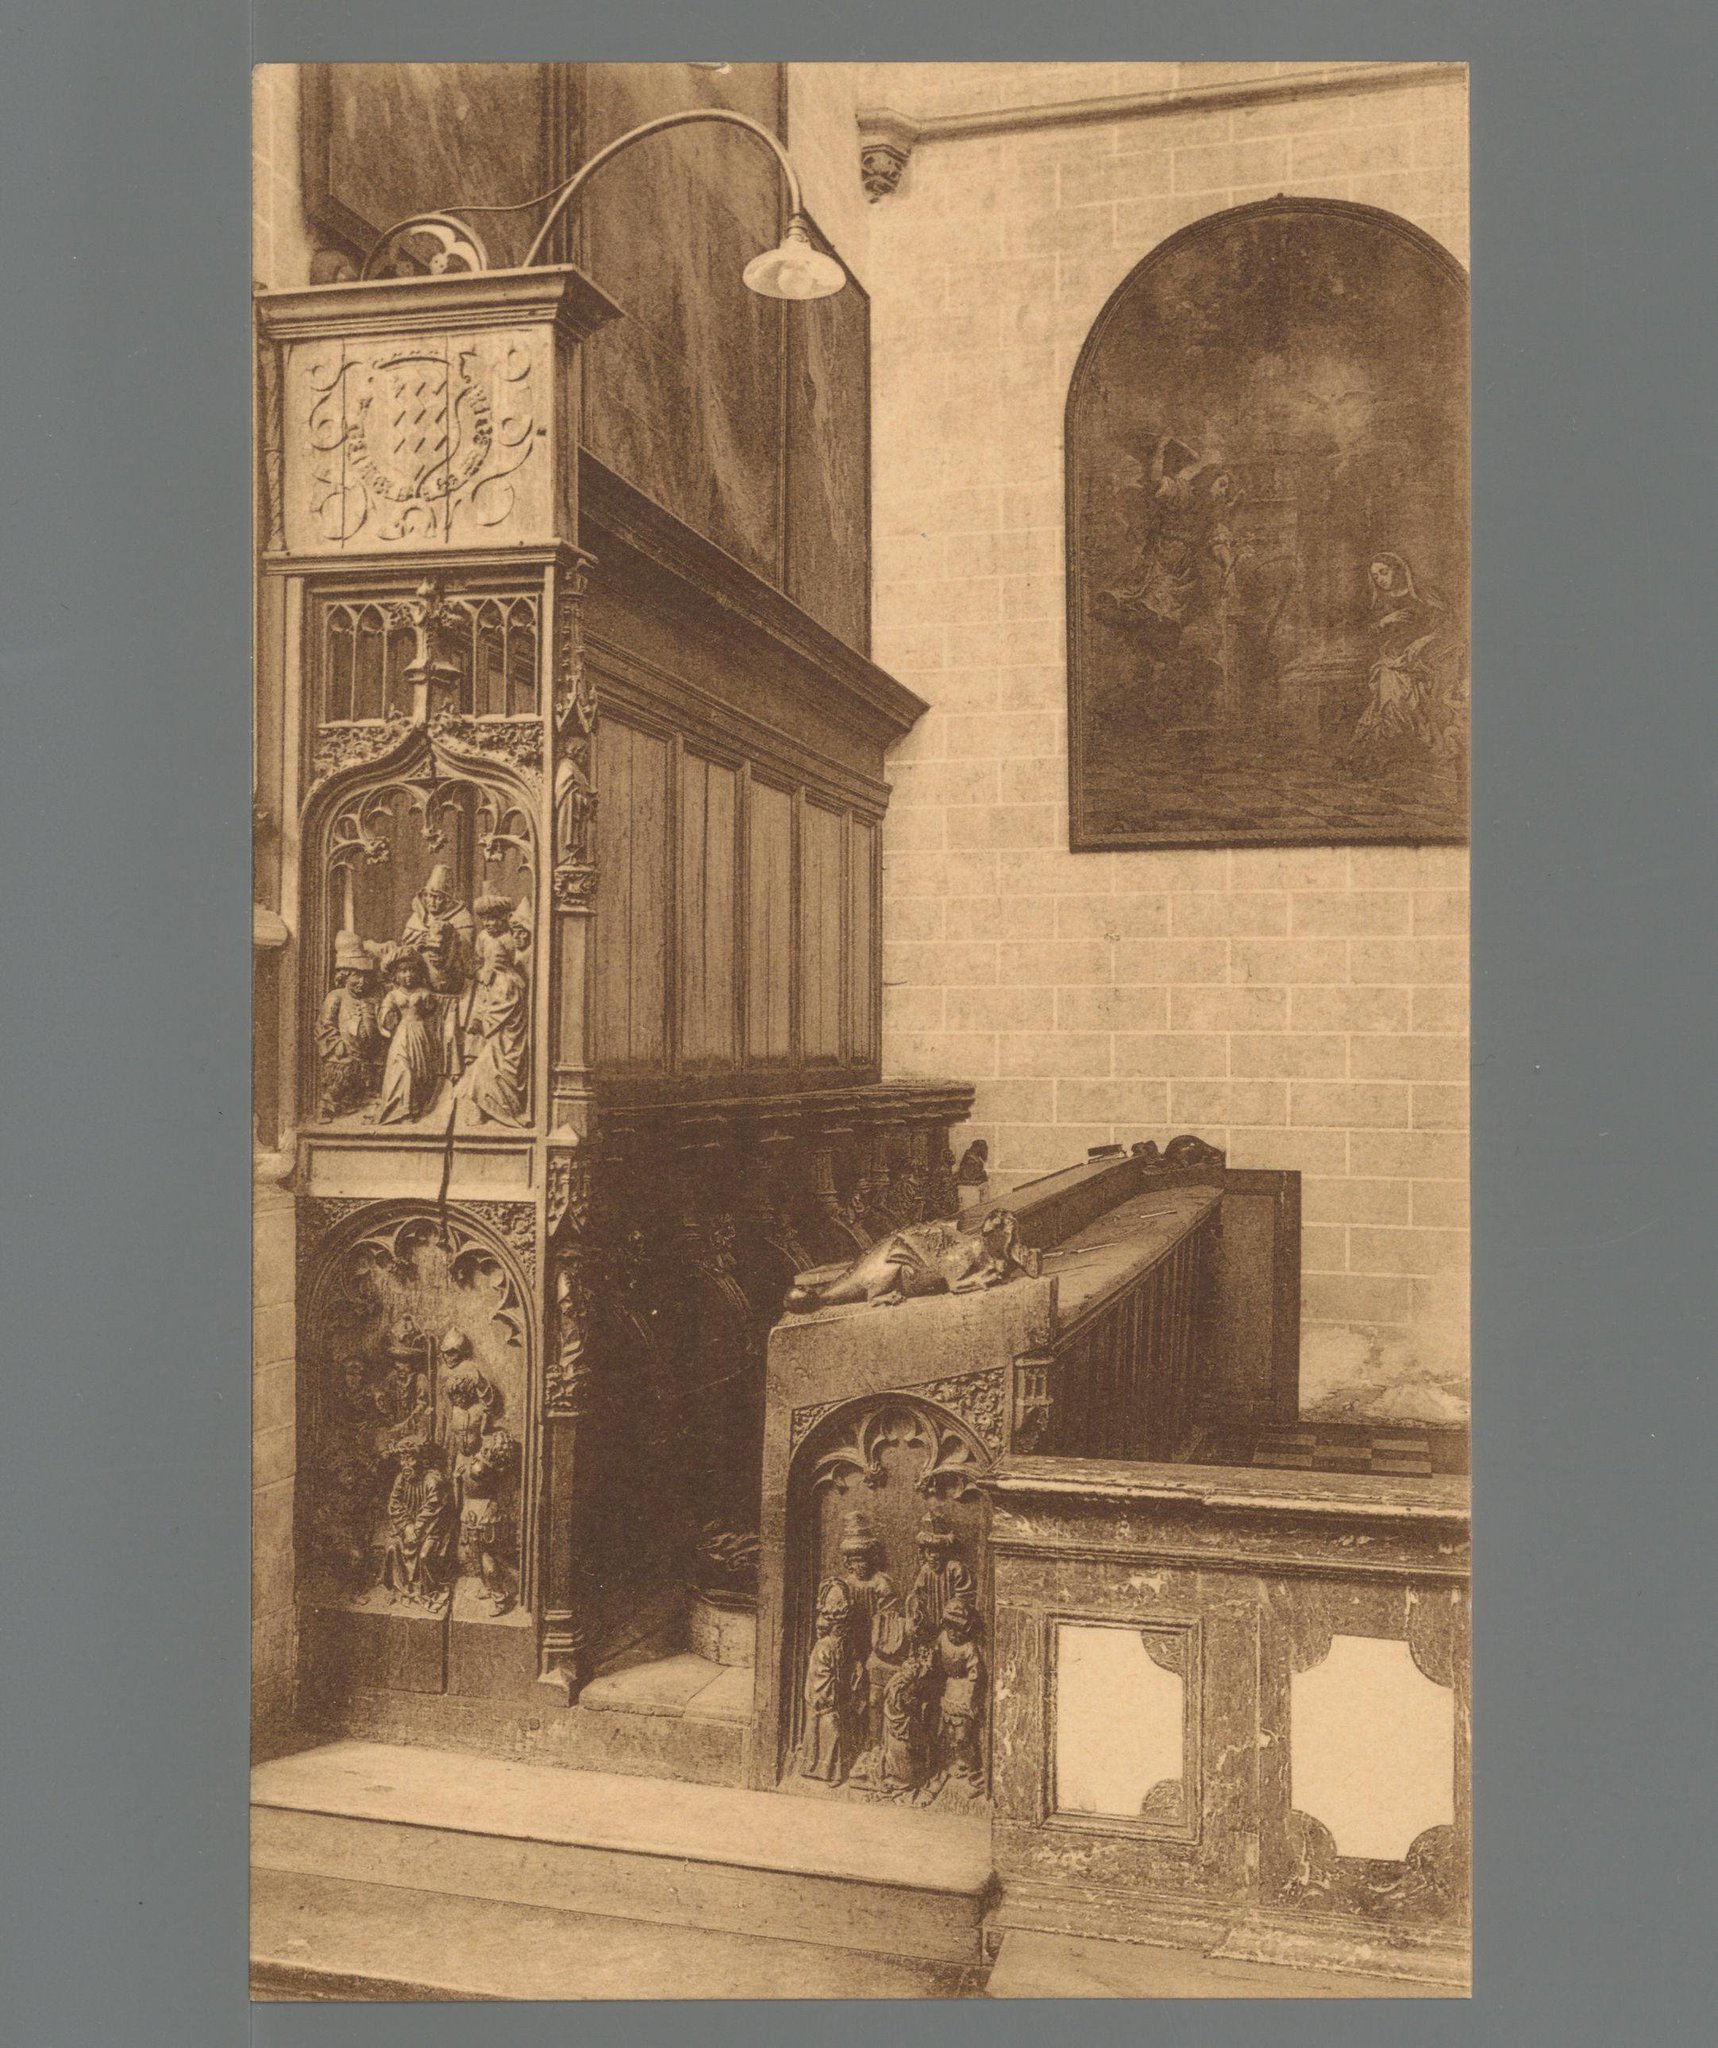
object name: ansichtkaart, prentbriefkaart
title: Hoogstraten. Praalgraf van A. de Lalaing en E.V. Culenberg, stichters der kerk van Sinte Katharina (...)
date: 1907-1913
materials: cardboard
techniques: photograph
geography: brussels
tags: grave, tomb, interior of church